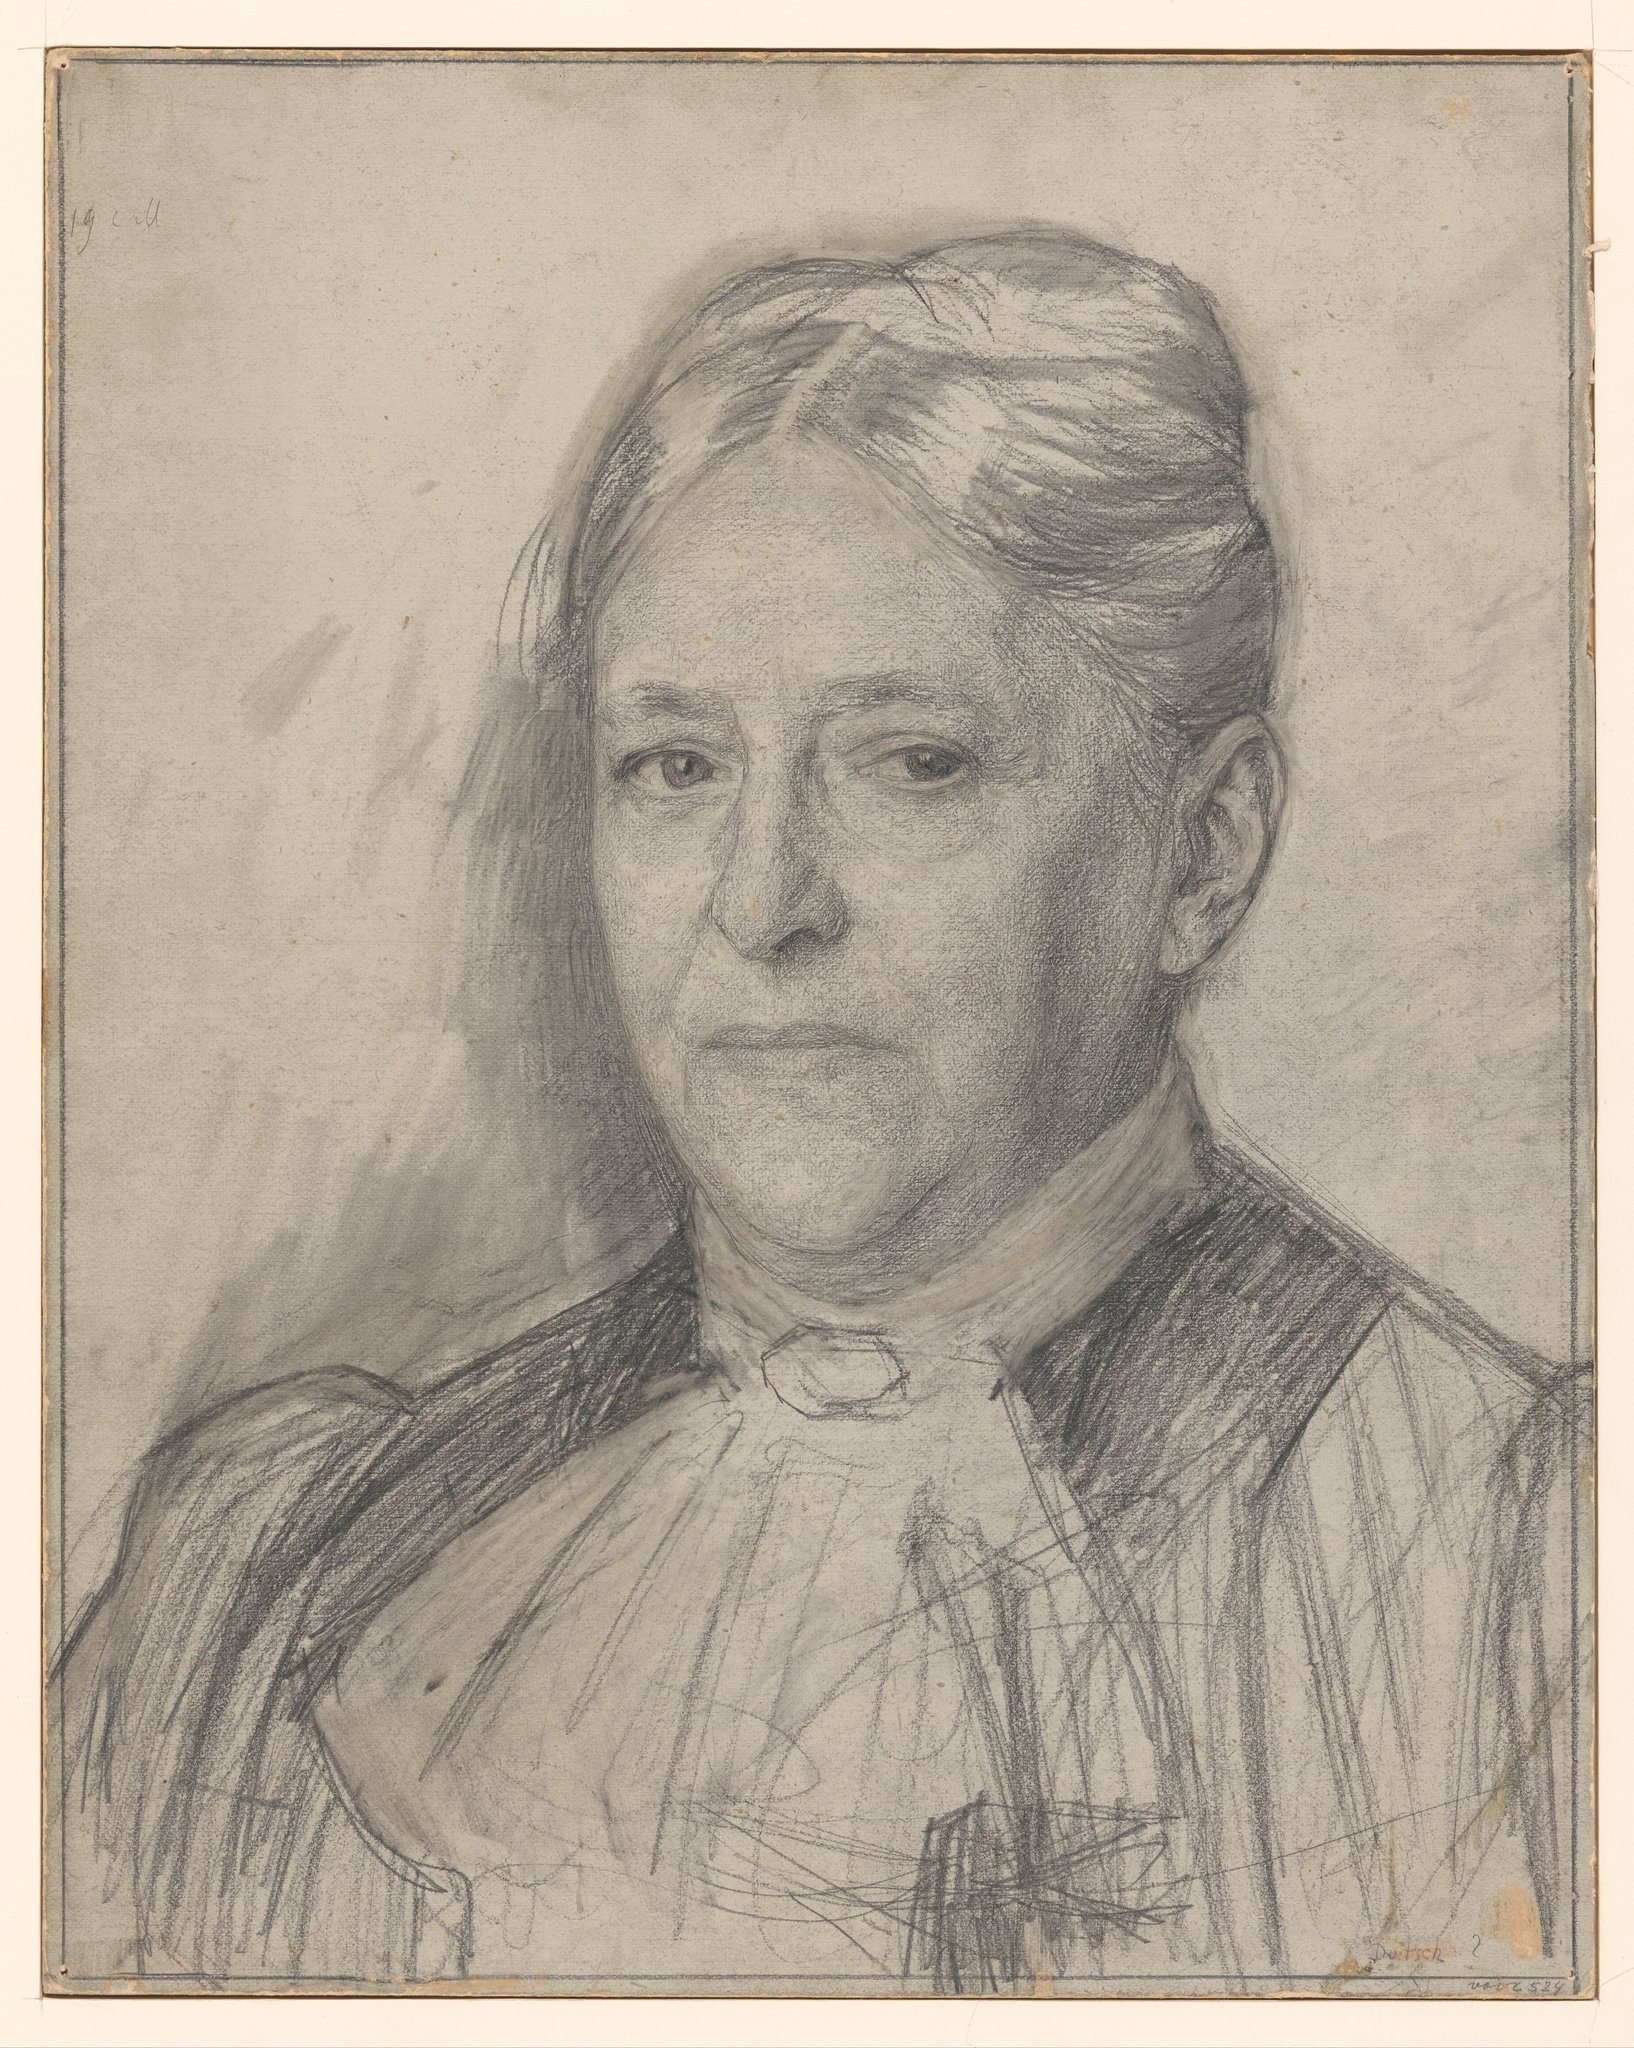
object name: drawing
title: Portret van Frau Bleichröder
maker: jan veth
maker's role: designer, draughtsman, painter, print maker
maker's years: 1864-1925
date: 1874-1925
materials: cardboard, chalk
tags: historical persons